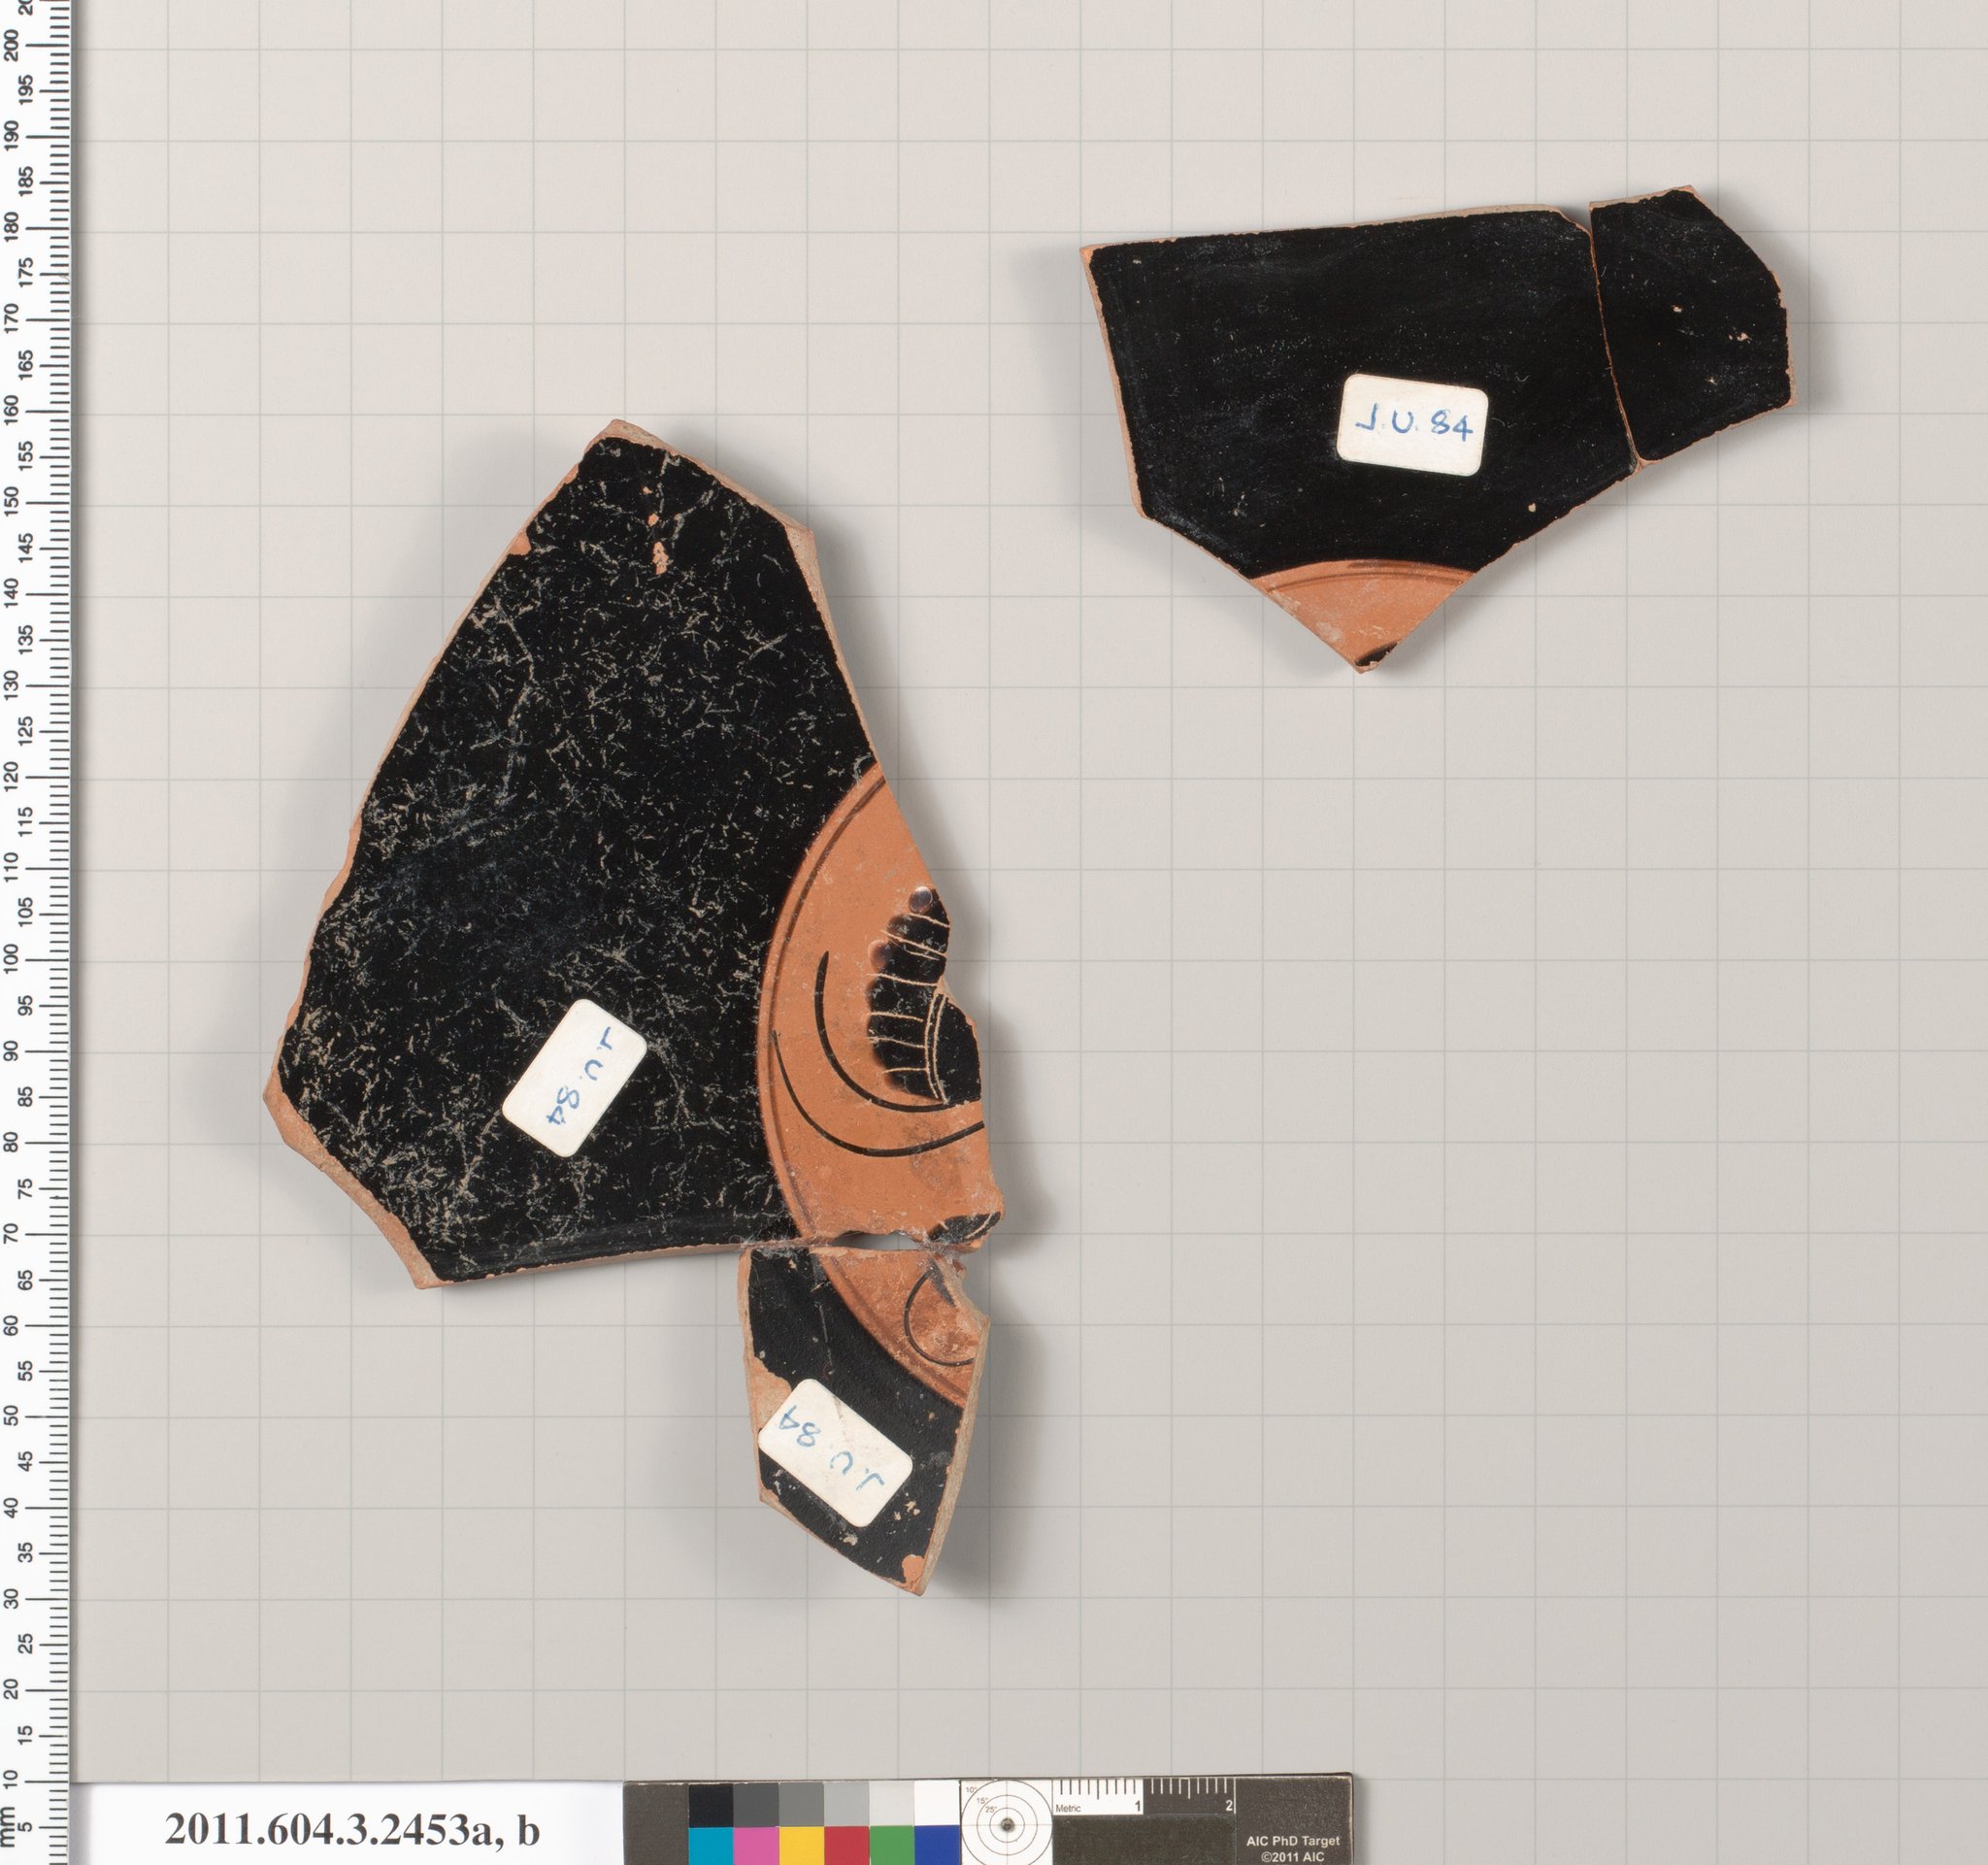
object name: kylix fragment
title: Terracotta fragments of a kylix (drinking cup)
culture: greek, attic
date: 530-510 BCE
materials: terracotta